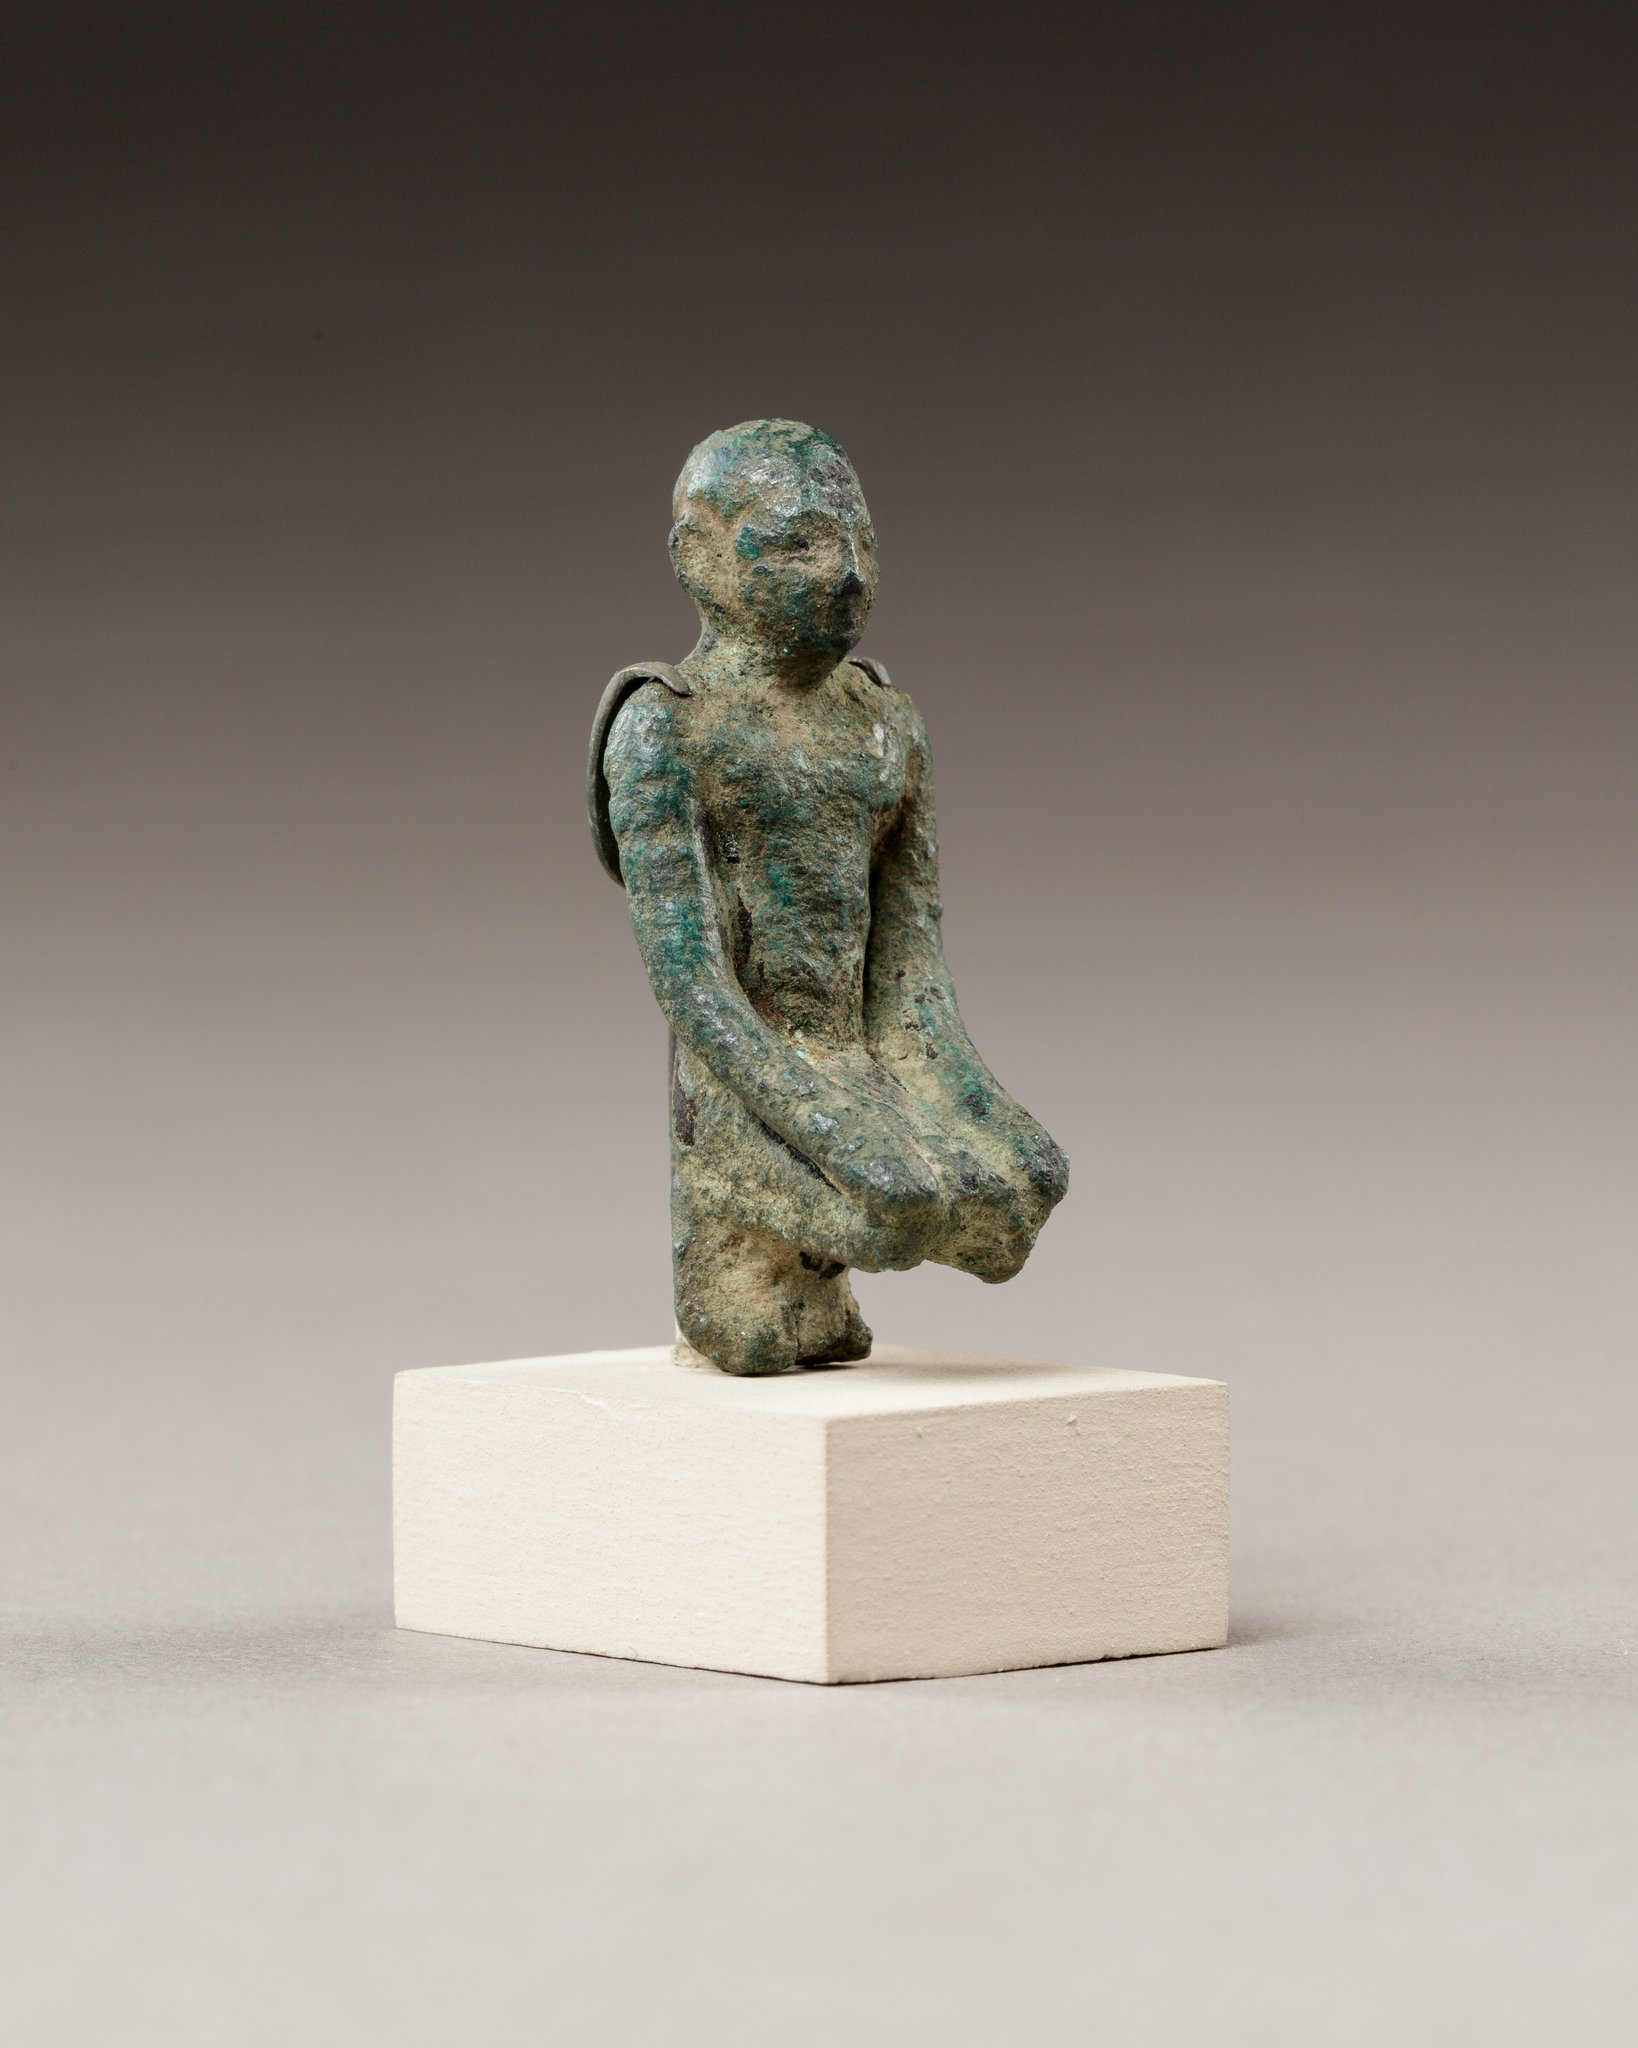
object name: figurine, devotée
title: Devotée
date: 664-630 BCE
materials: alloy, bronze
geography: egypt